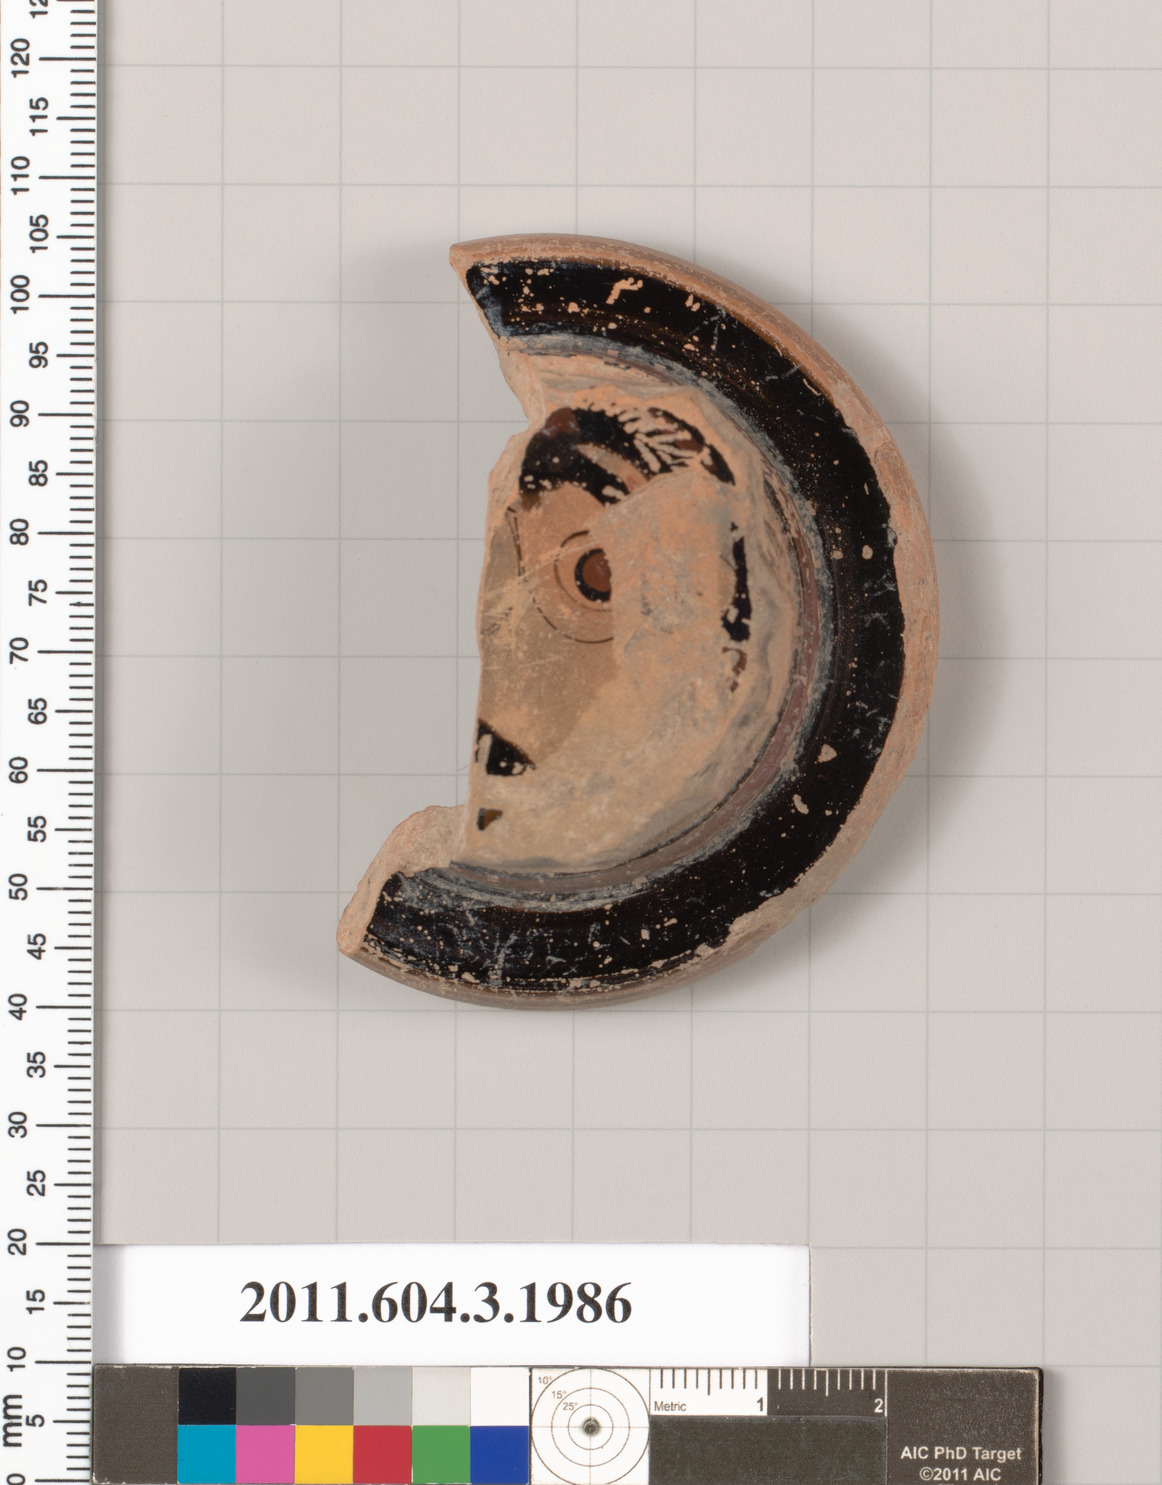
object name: kylix fragment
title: Terracotta fragment of a stemless cup (drinking cup)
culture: greek, attic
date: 550-526 BCE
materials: terracotta